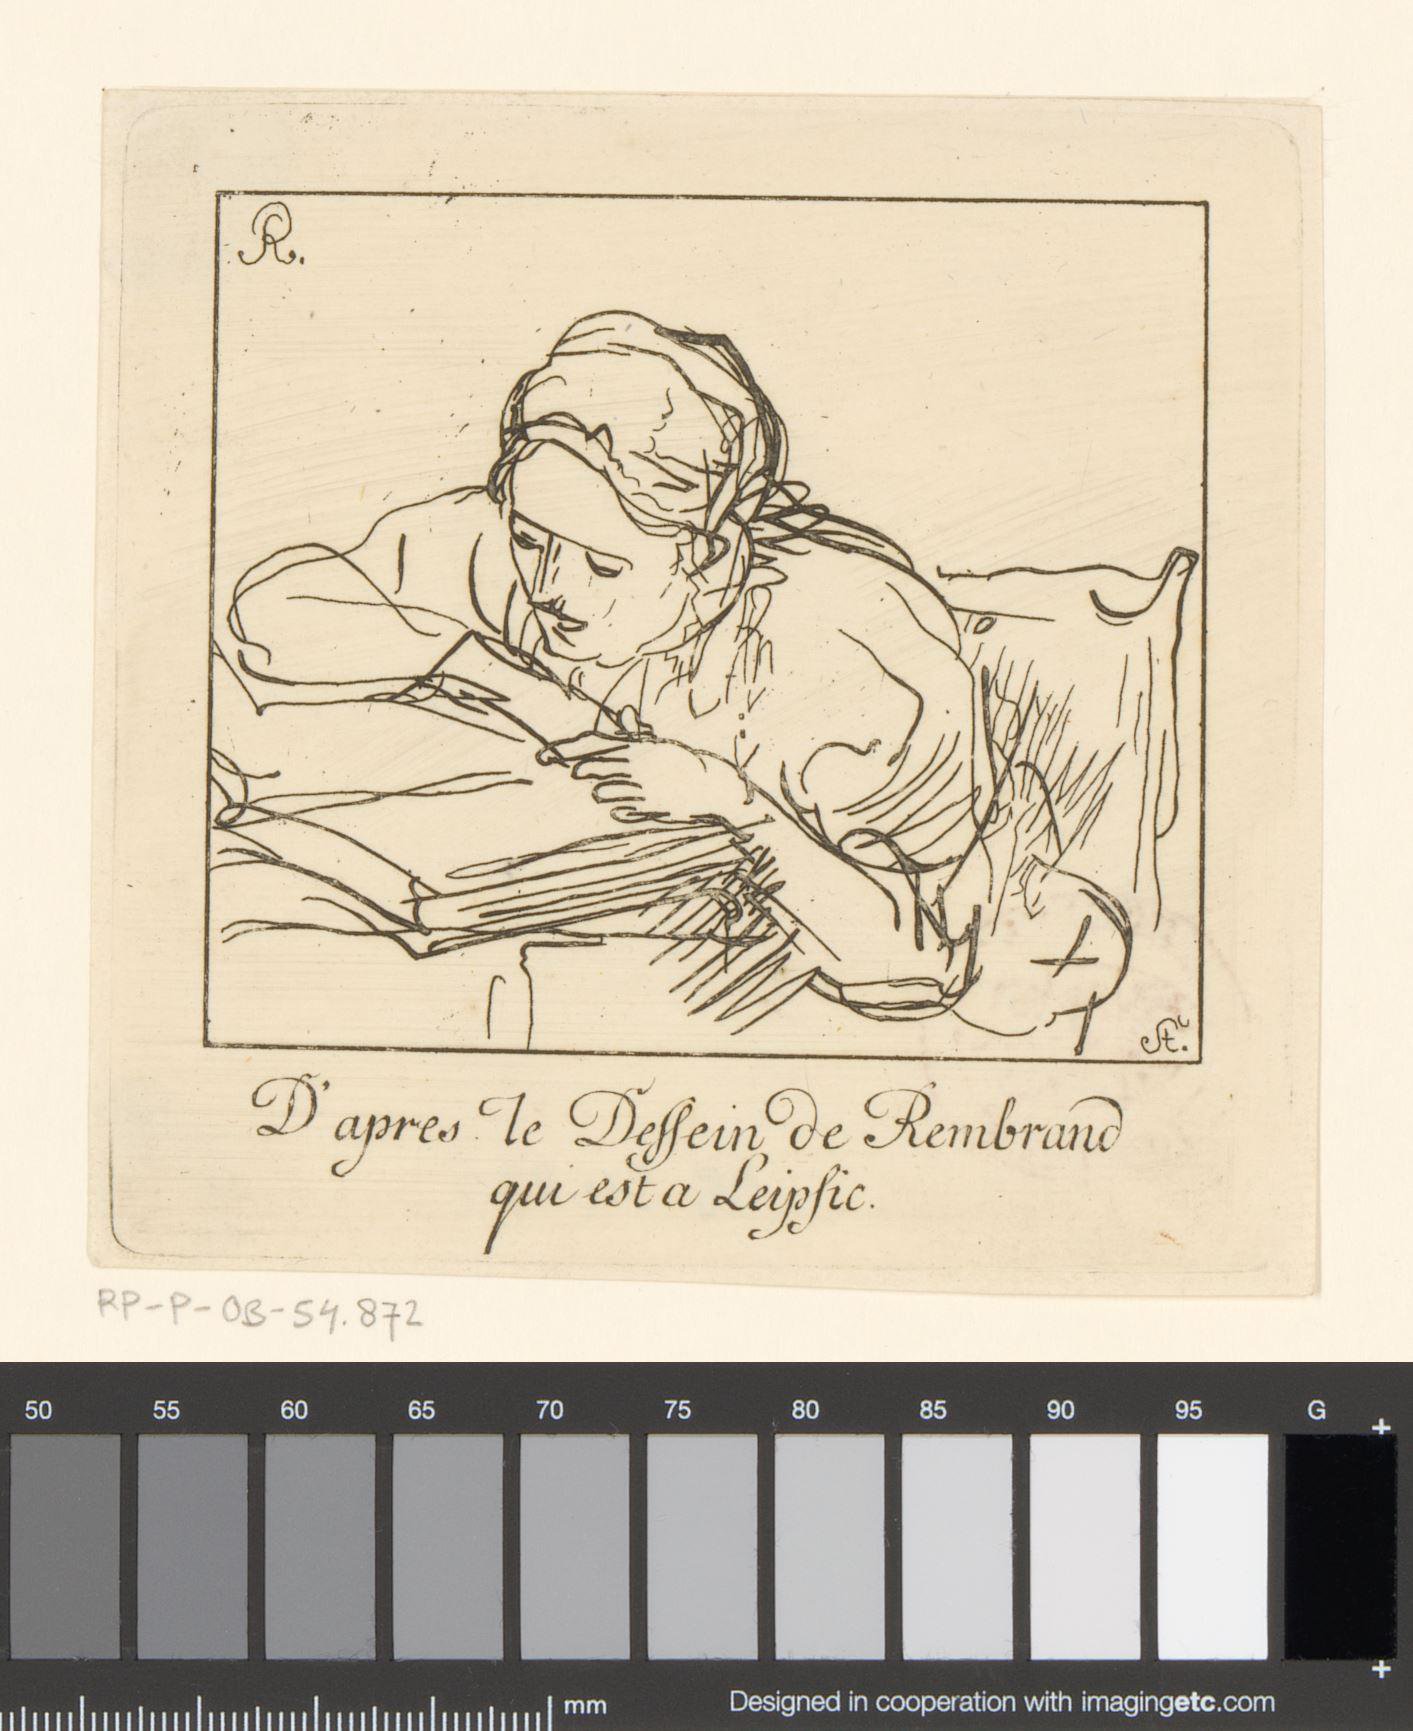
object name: print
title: Lezende vrouw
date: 1737-1787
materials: paper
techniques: etching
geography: germany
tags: adult woman, reading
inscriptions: collector's mark: Lugt 240